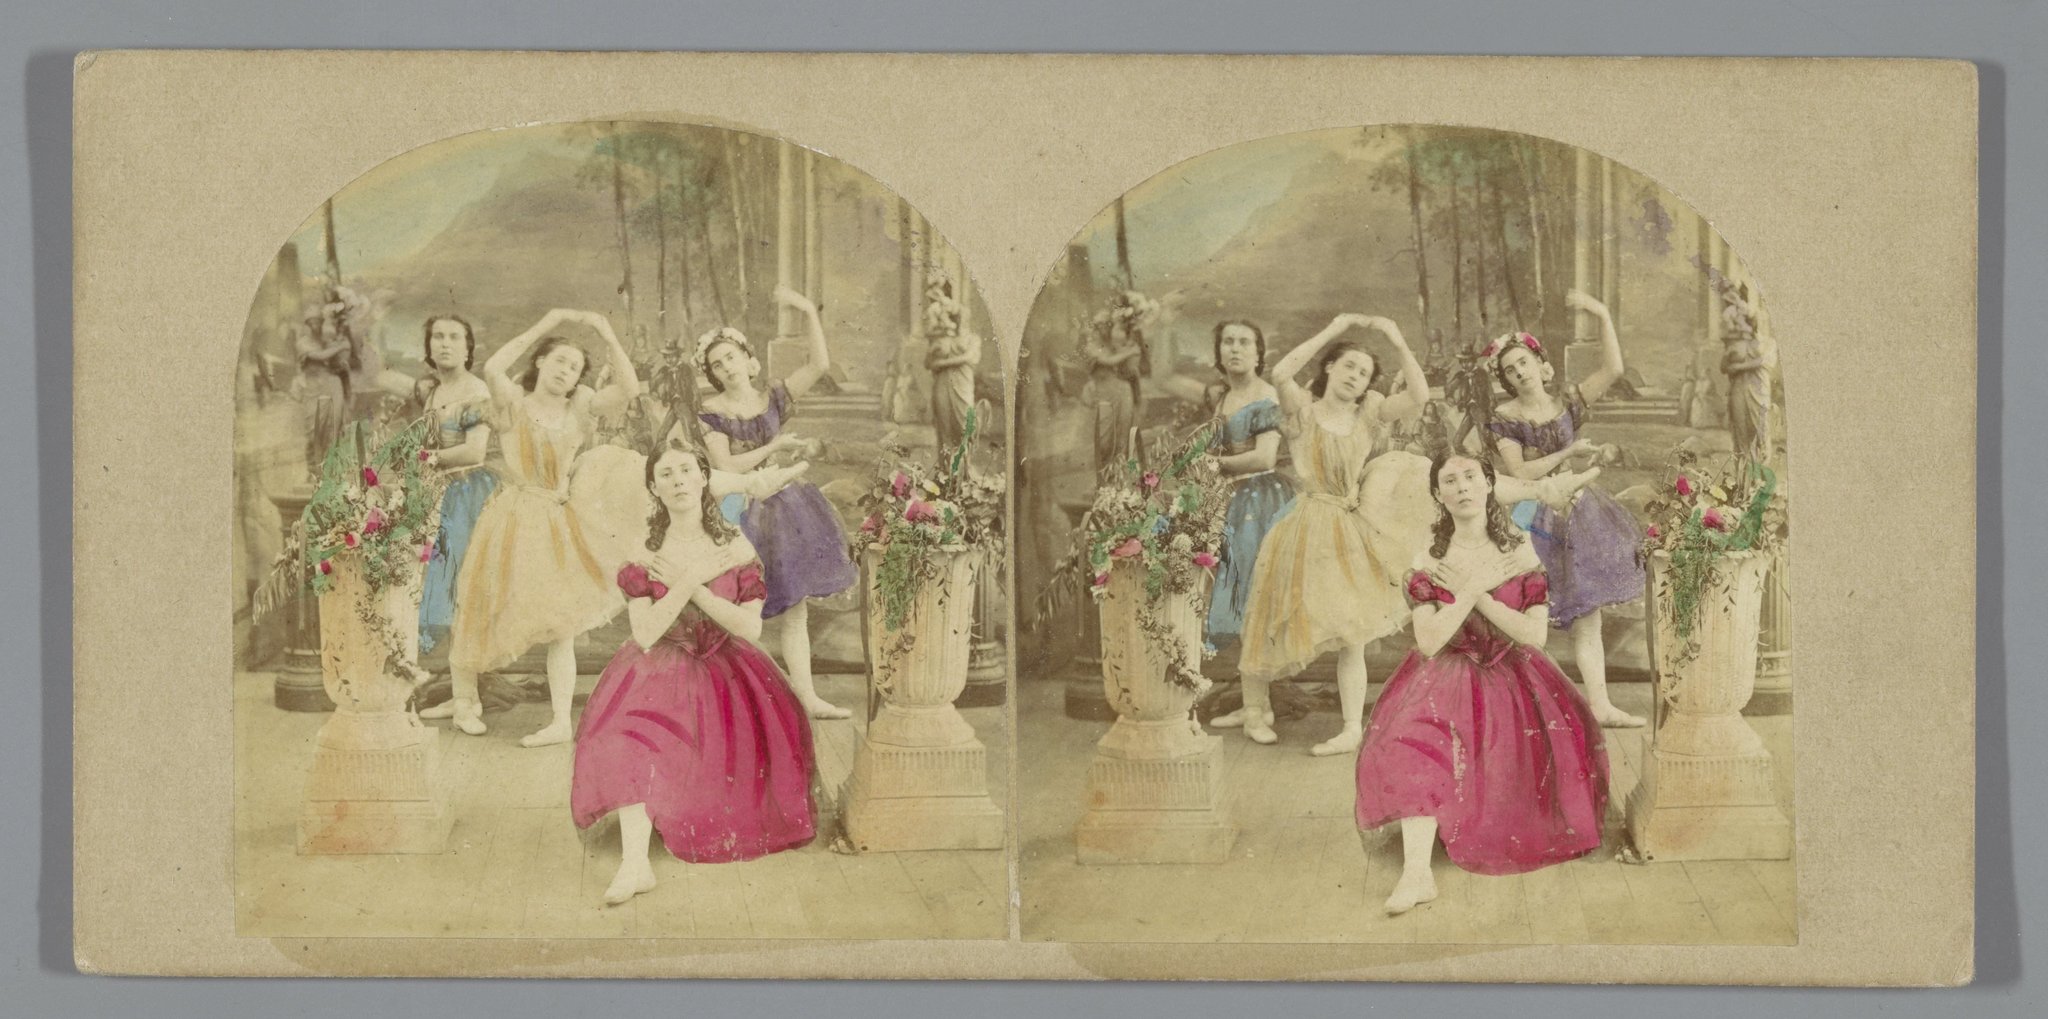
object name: stereograph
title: Vier danseressen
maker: Anonymous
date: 1852-1863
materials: cardboard, paper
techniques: albumen print, hand coloring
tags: performer, artiste (non-work situations)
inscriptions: inscription: ‘111’, inscription: ‘P’, inscription: ‘H.5.’, inscription, inscription: ‘No. 00’